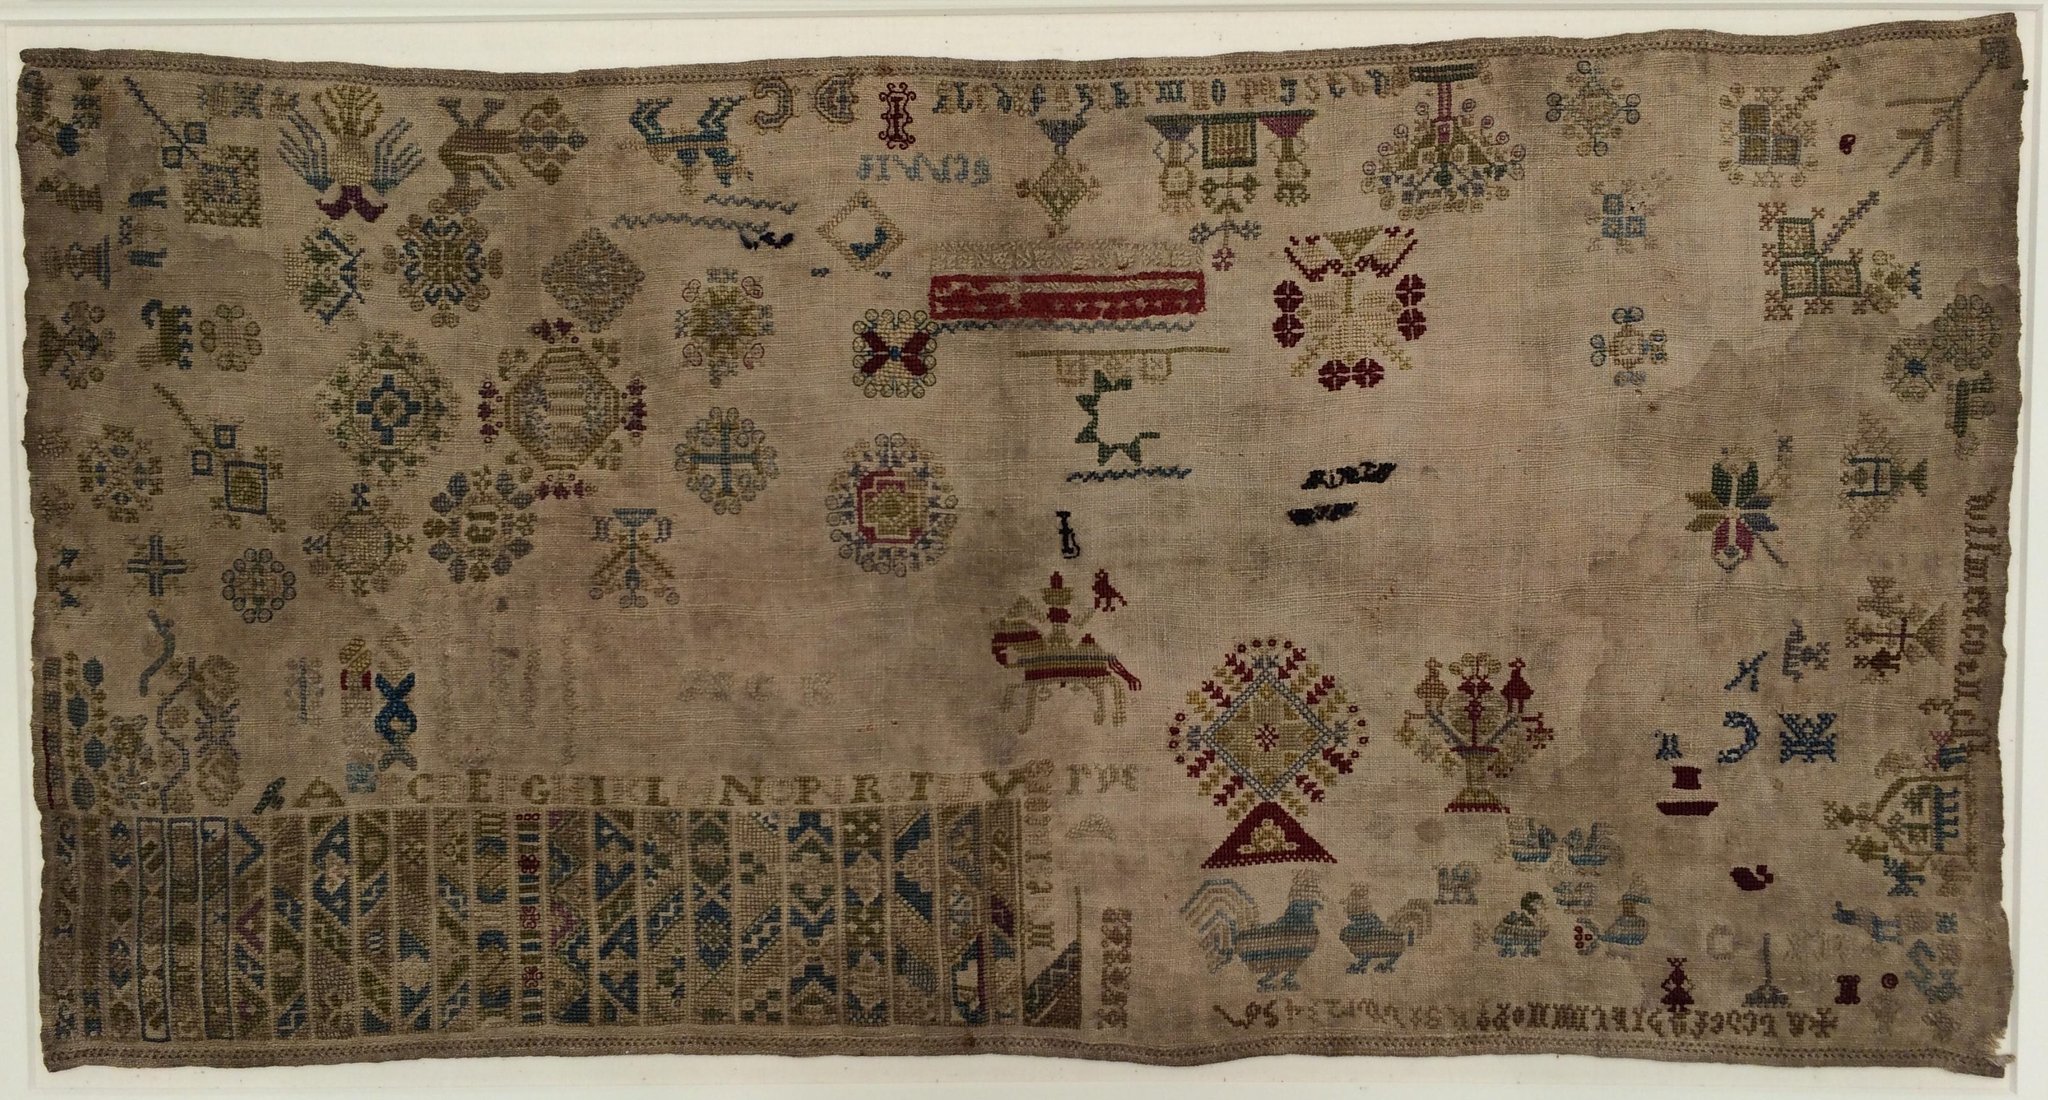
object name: sampler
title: Embroidered sampler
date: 1601-1700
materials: linen, silk, wool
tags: animals,birds,flowers